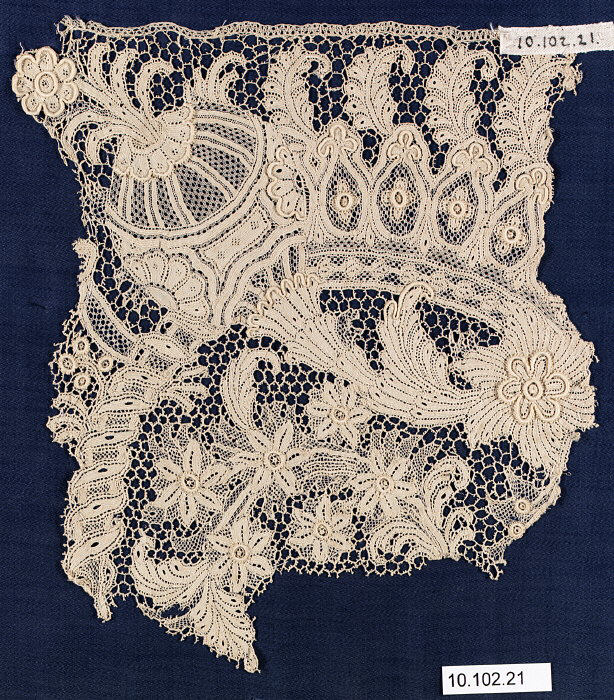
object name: fragment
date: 1701-1733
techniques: lace